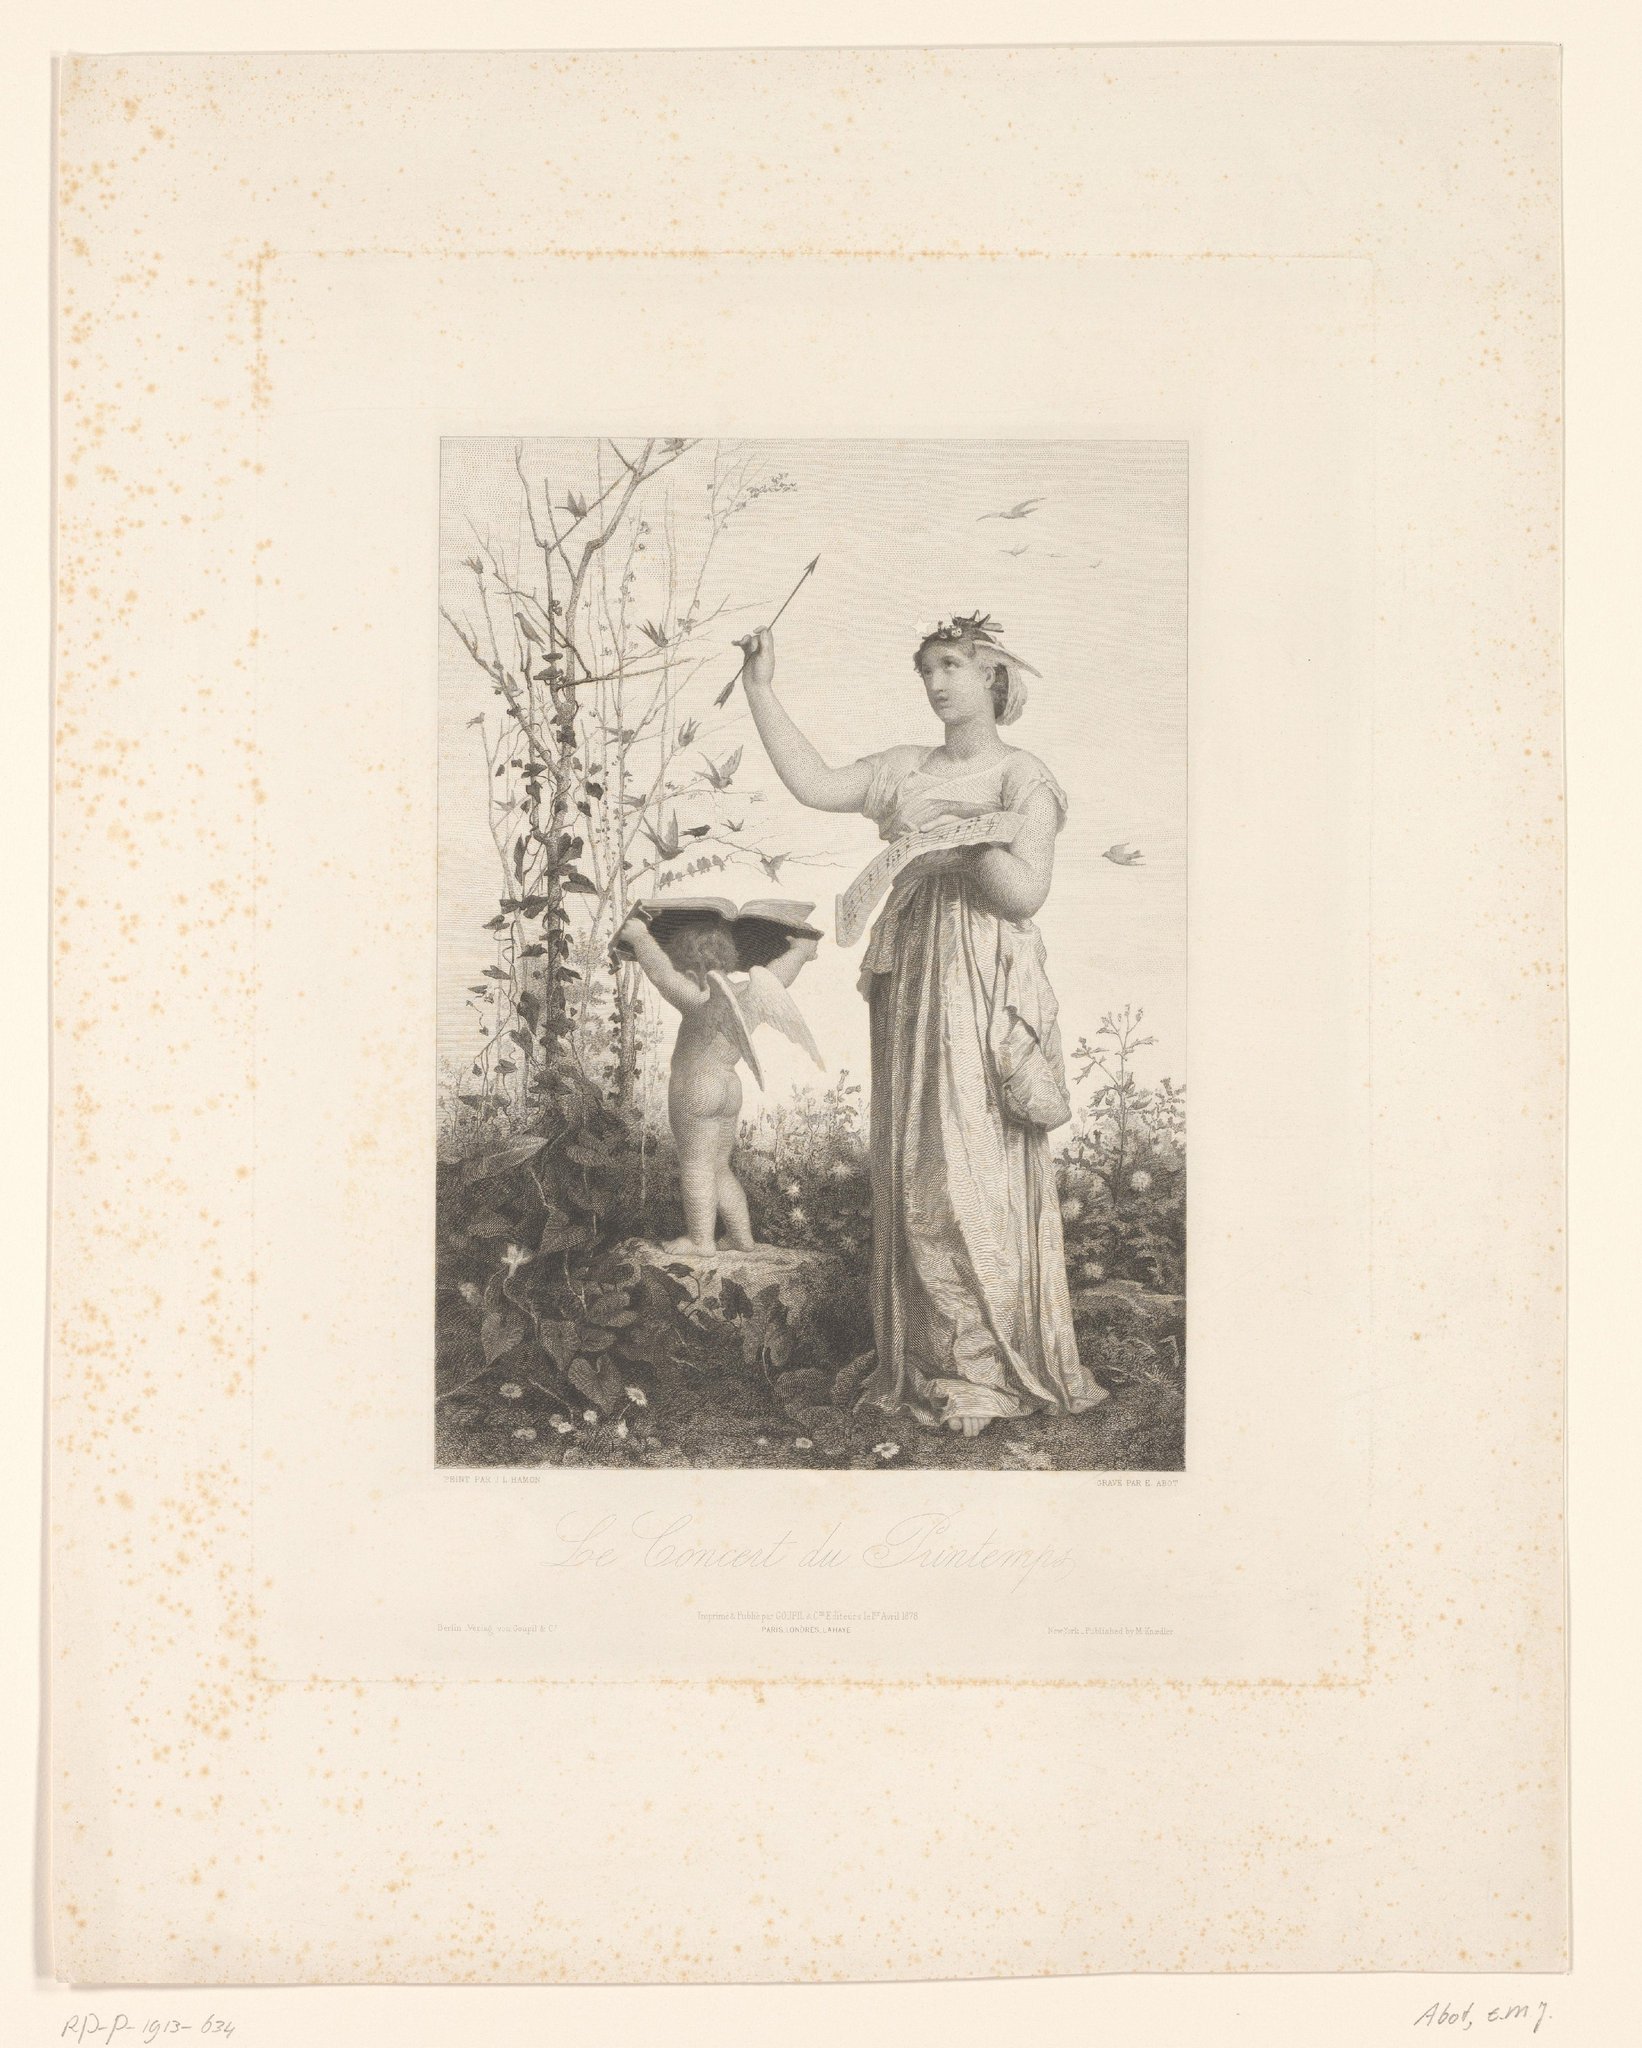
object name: print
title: Le Concert du Printemps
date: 1878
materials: paper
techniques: engraving, etching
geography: new york city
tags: notation of music, trees, birds, book, standing figure - aa - female human figure, insects: cricket, cupids: 'amores', 'amoretti', 'putti'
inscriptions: collector's mark: Lugt 2228